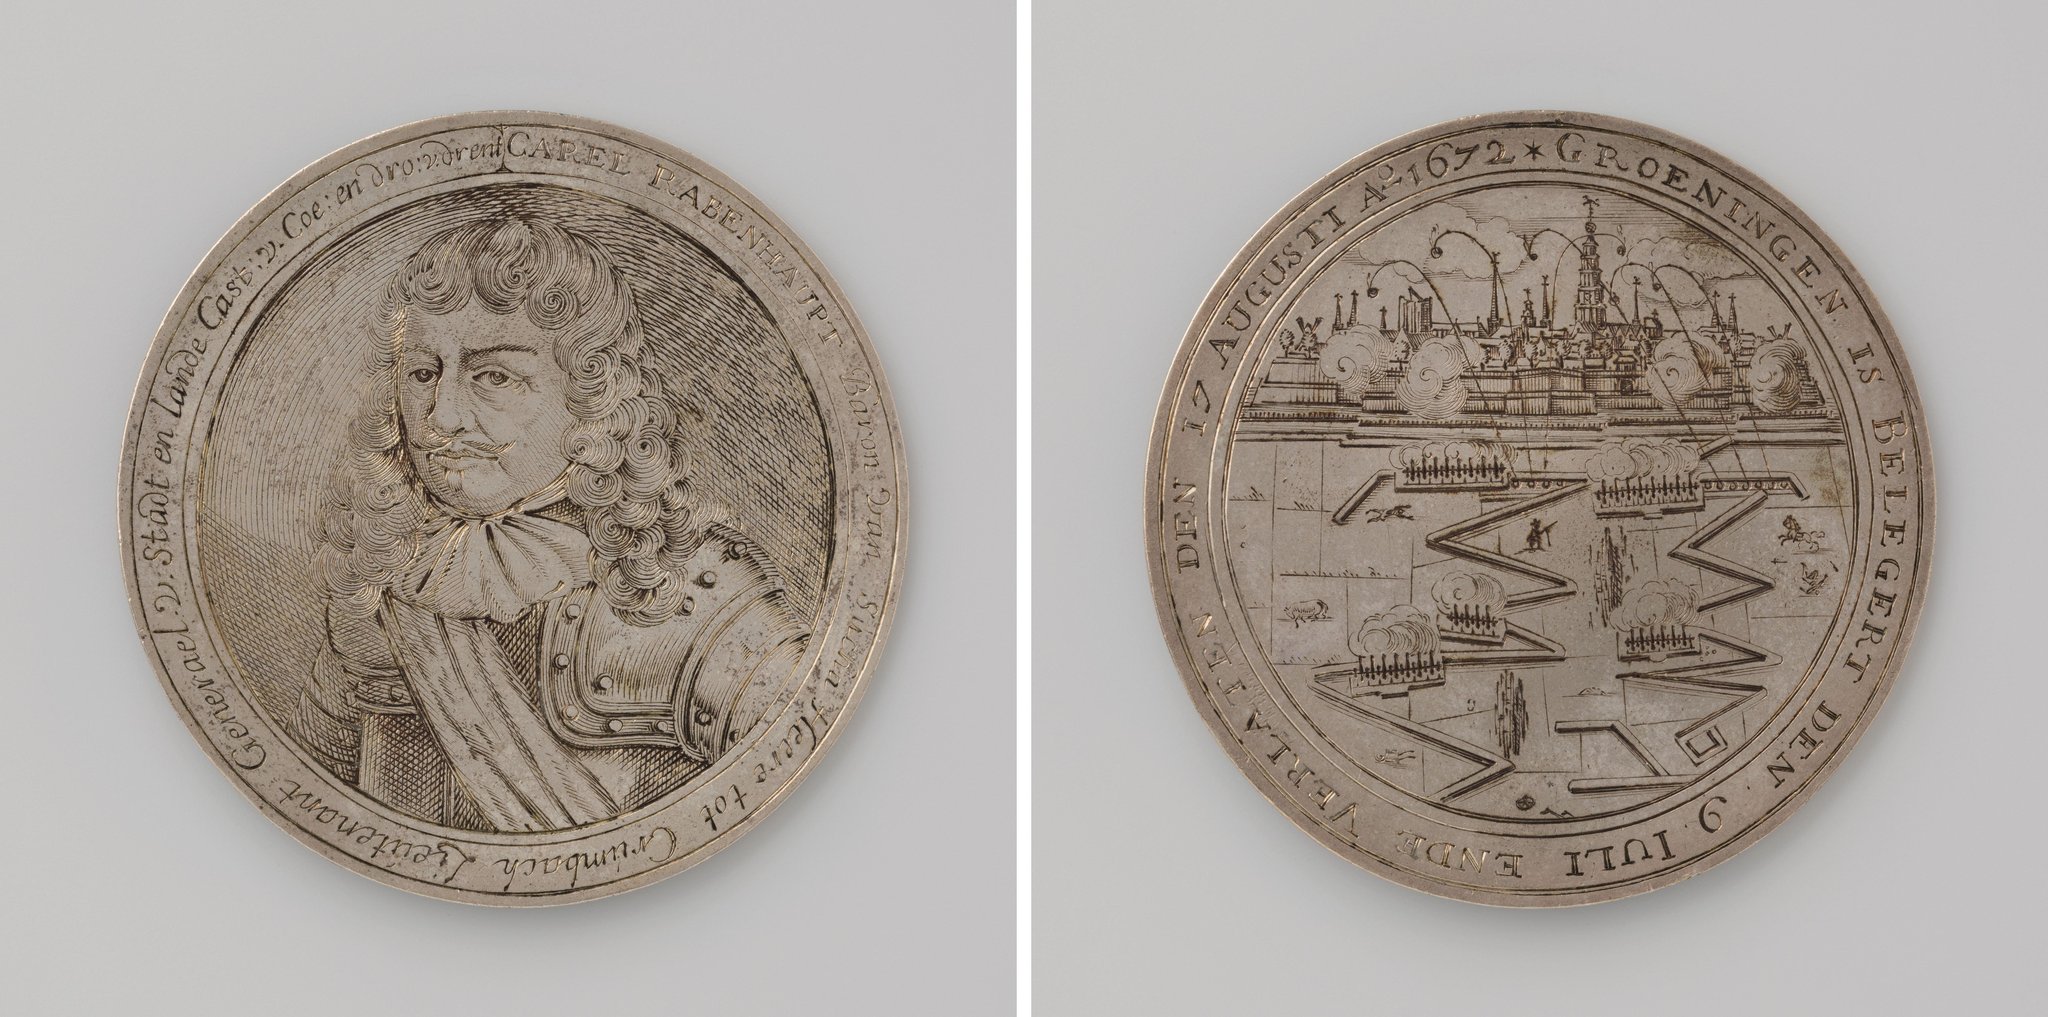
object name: honorary medal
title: Beleg van Groningen, ter ere van Carel Rabenhaupt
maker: Anonymous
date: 1672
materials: silver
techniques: casting, engraving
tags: rampjaar (disaster year)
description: Zilveren penning. Voorzijde: borststuk man binnen omschrift. Keerzijde: gezicht op stad en belegeraars tijdens beschieting binnen omschrift.